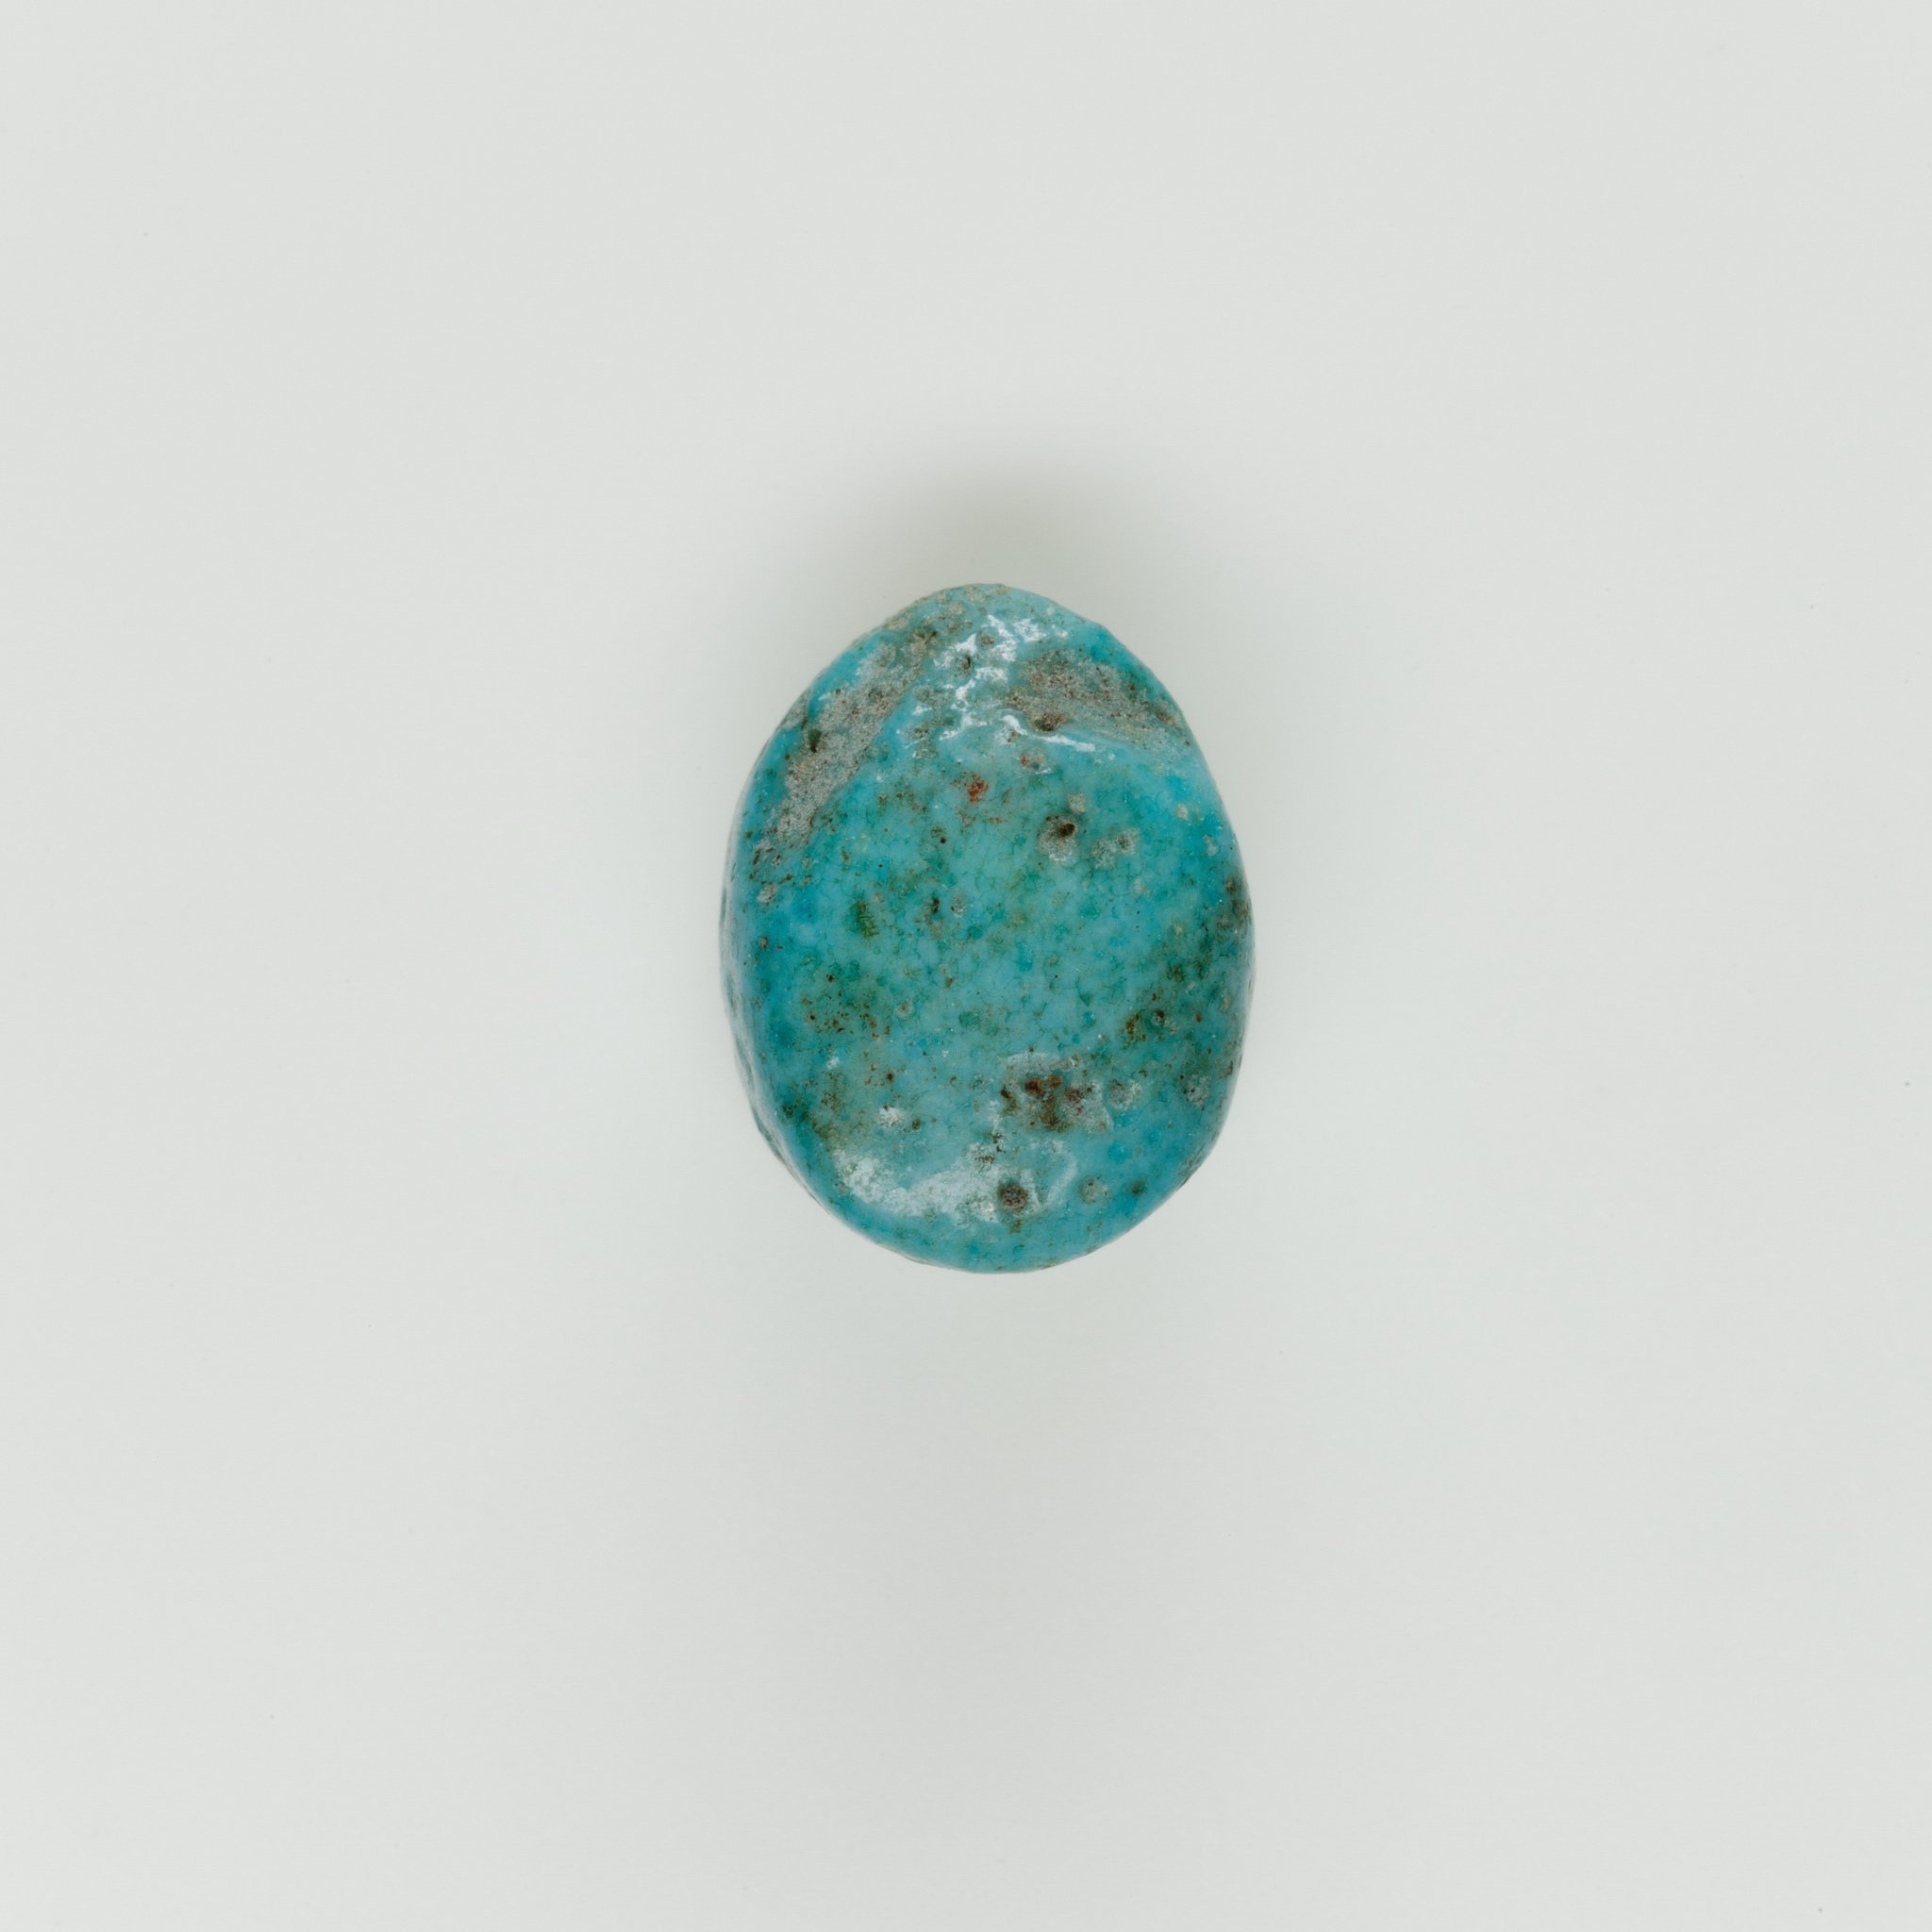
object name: bead, scarab, amenemhat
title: Uninscribed Scaraboid Bead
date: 1504-1447 BCE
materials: faience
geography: egypt